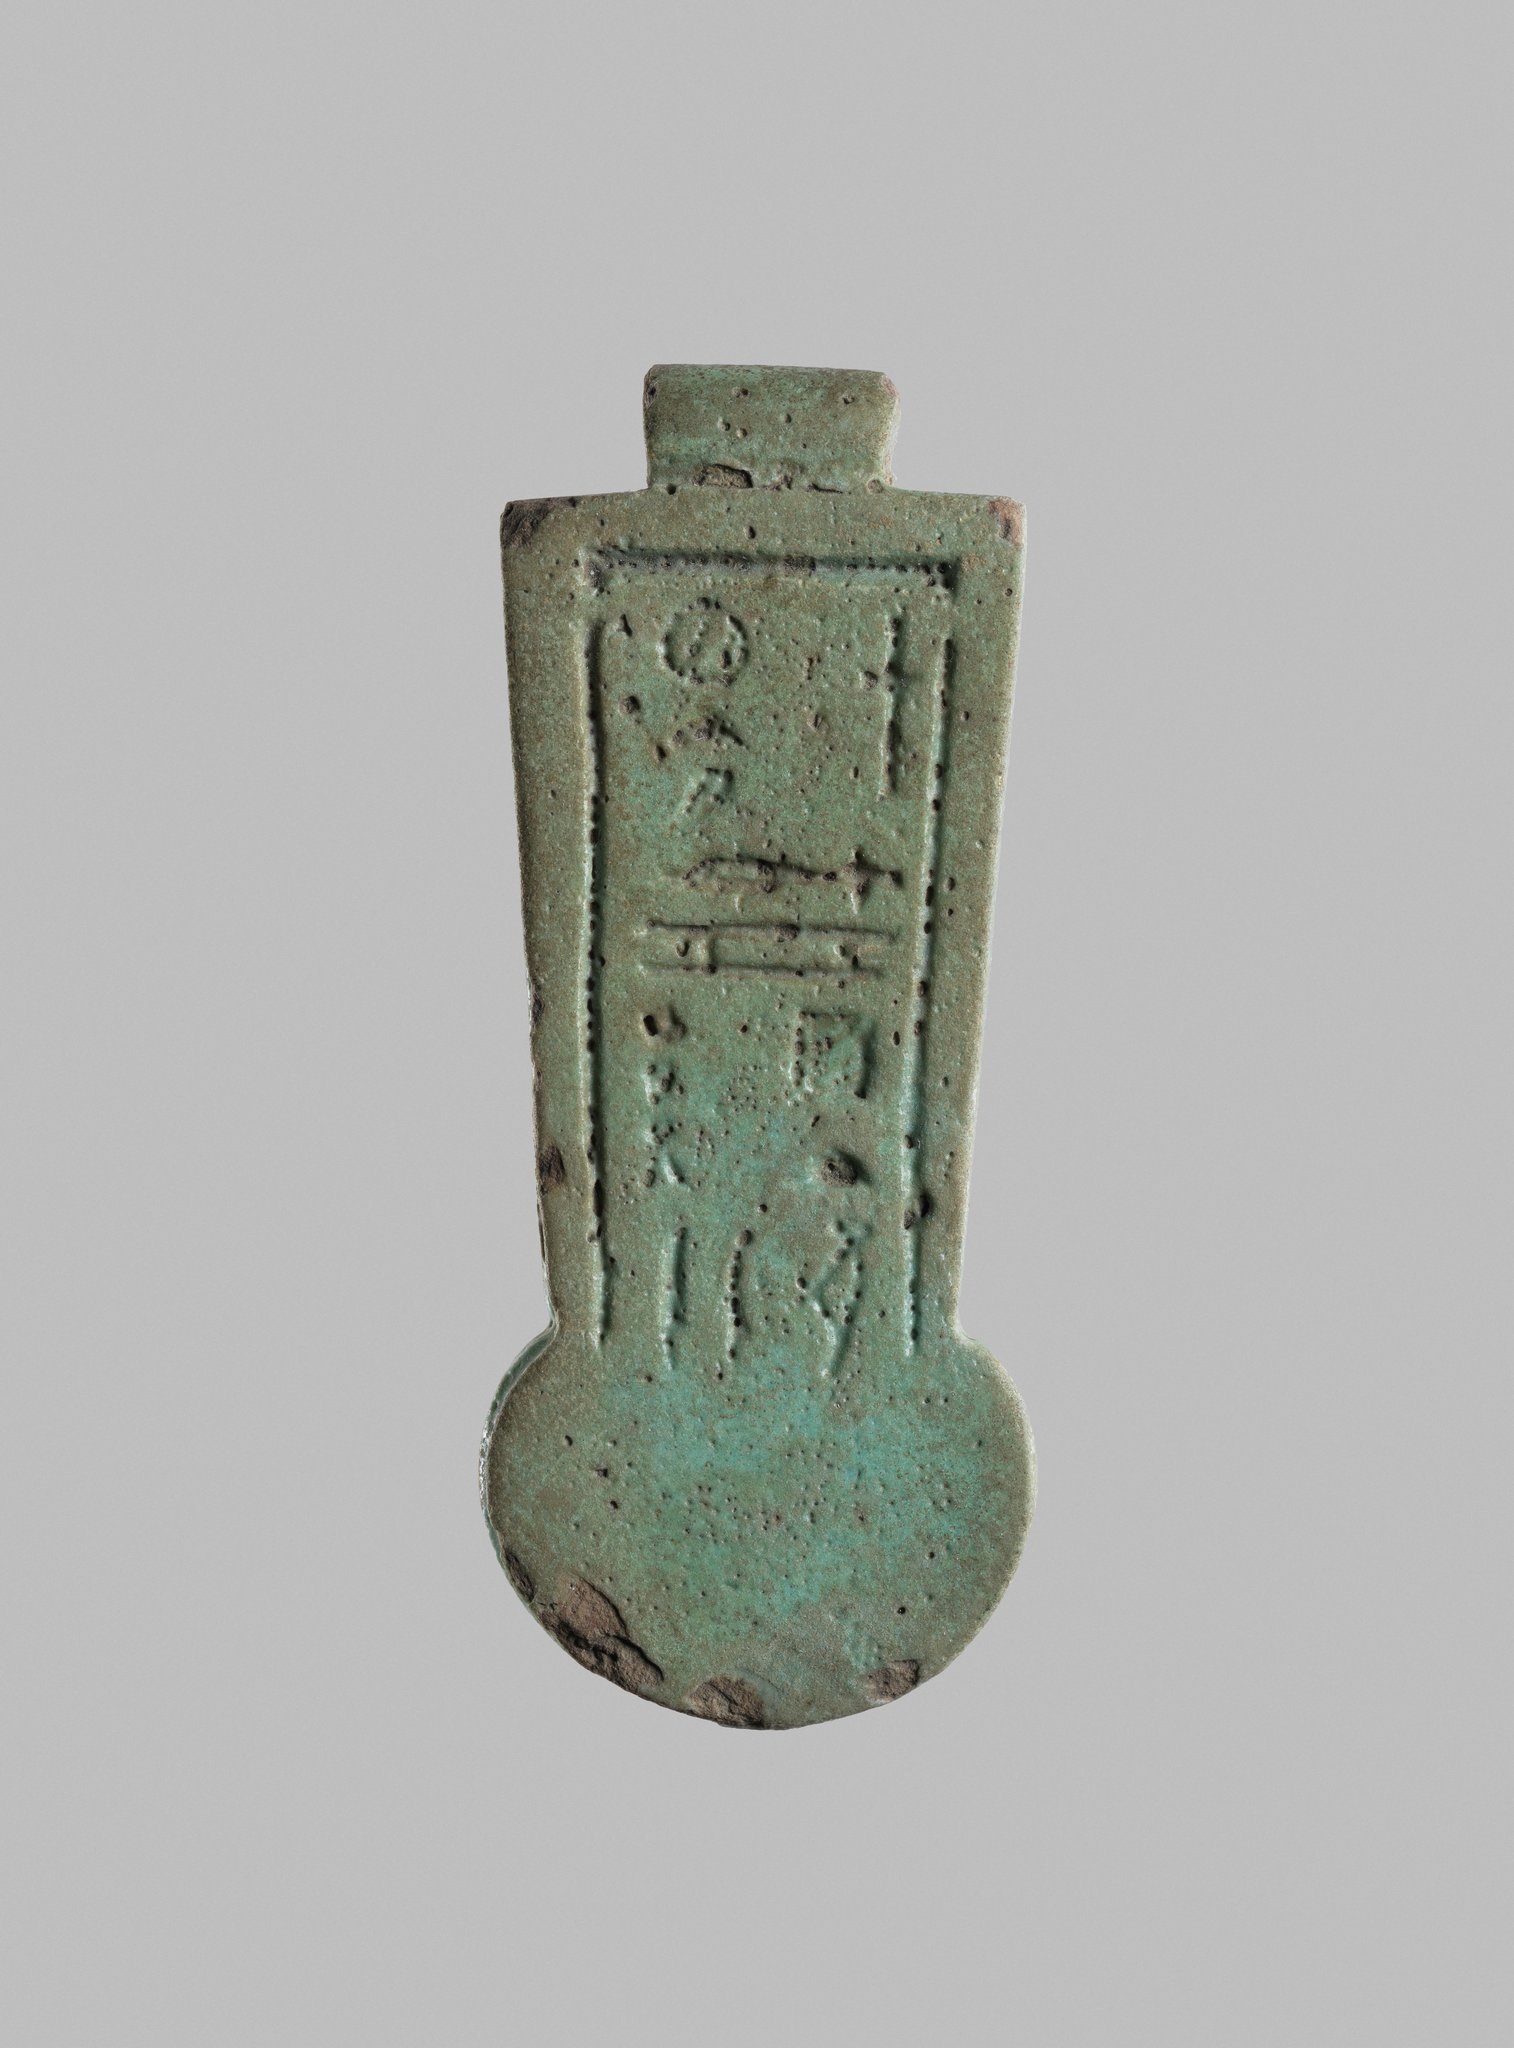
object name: menat counterpoise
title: Menat inscribed beloved of great Sakhmet, beloved of Ptah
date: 664-332 BCE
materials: faience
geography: egypt